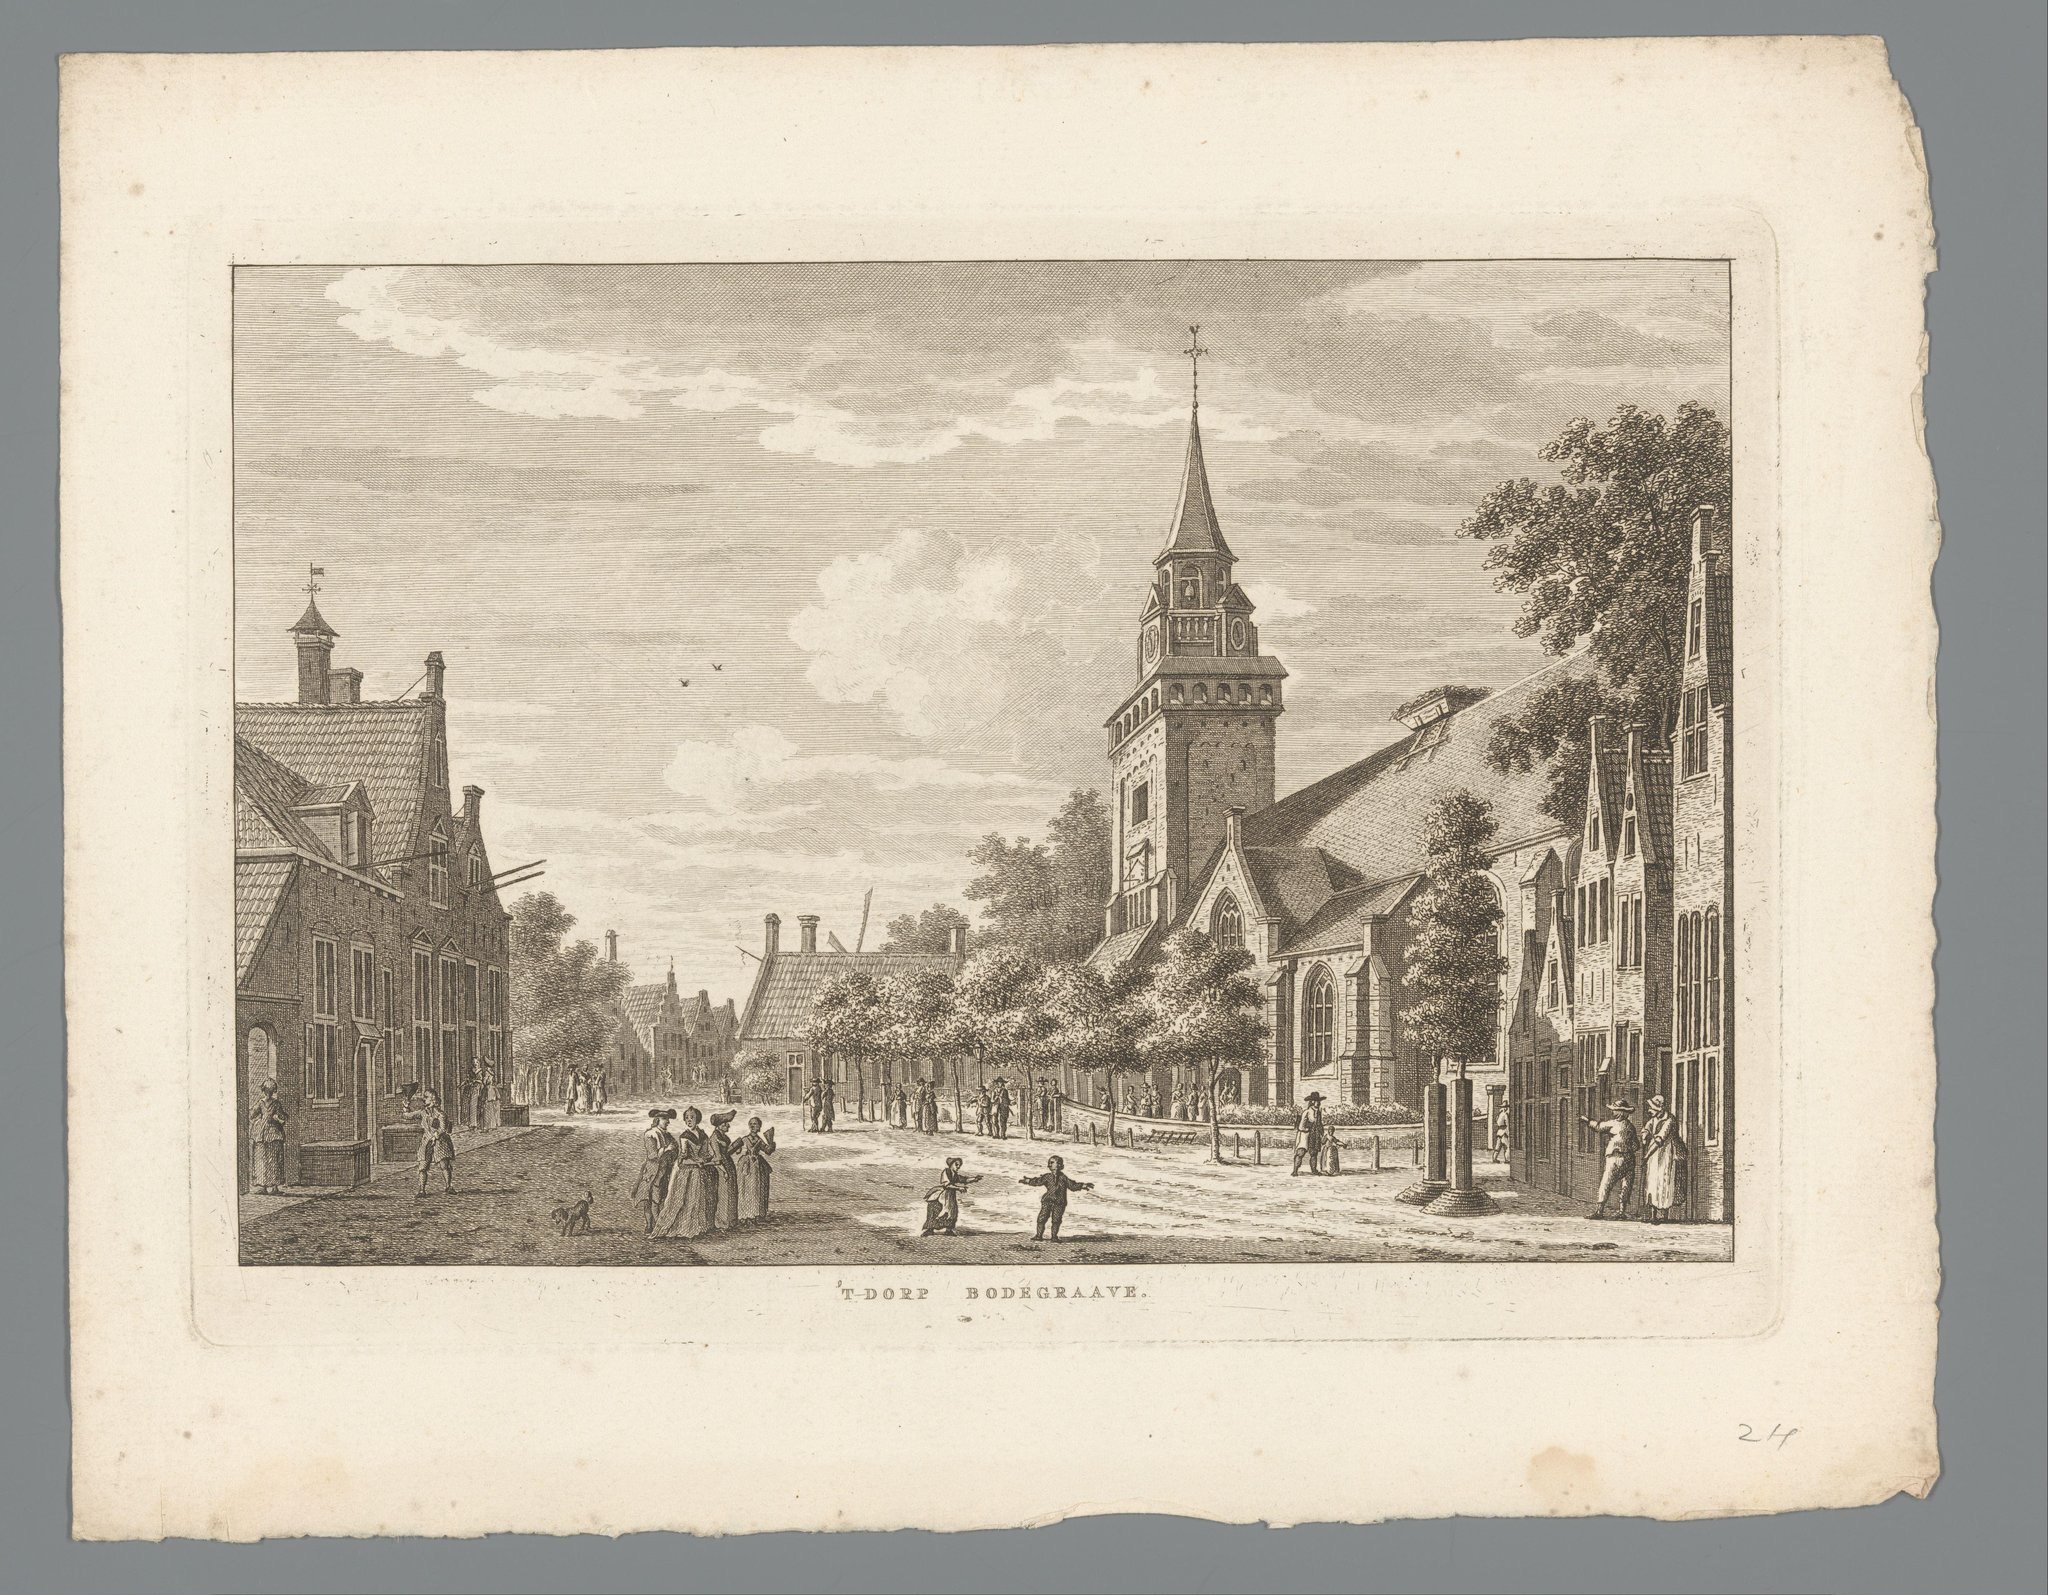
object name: print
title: 't Dorp Bodegraave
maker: carel frederik bendorp (i)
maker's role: print maker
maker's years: 1736-1814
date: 1786-1792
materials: paper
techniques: etching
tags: church (exterior), public road in village (+ city(-scape) with figures, staffage), bodegraven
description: Prent uit: Vaderlandsche gezichten, of afbeeldingen van den tegenwoordigen staat der Vereenigde Nederlanden (…). Amsterdam: Hendrik Gartman, Willem Vermandel en Jan Willem Smit, 1786-1792. Uitgegeven in afleveringen met ieder een eigen bifolium en inhoudsopgave. Alle prenten in deze publicatie zijn gegraveerd door Carel Frederik Bendorp (I) en, in de meeste gevallen, gebaseerd op tekeningen van Jan Bulthuis.